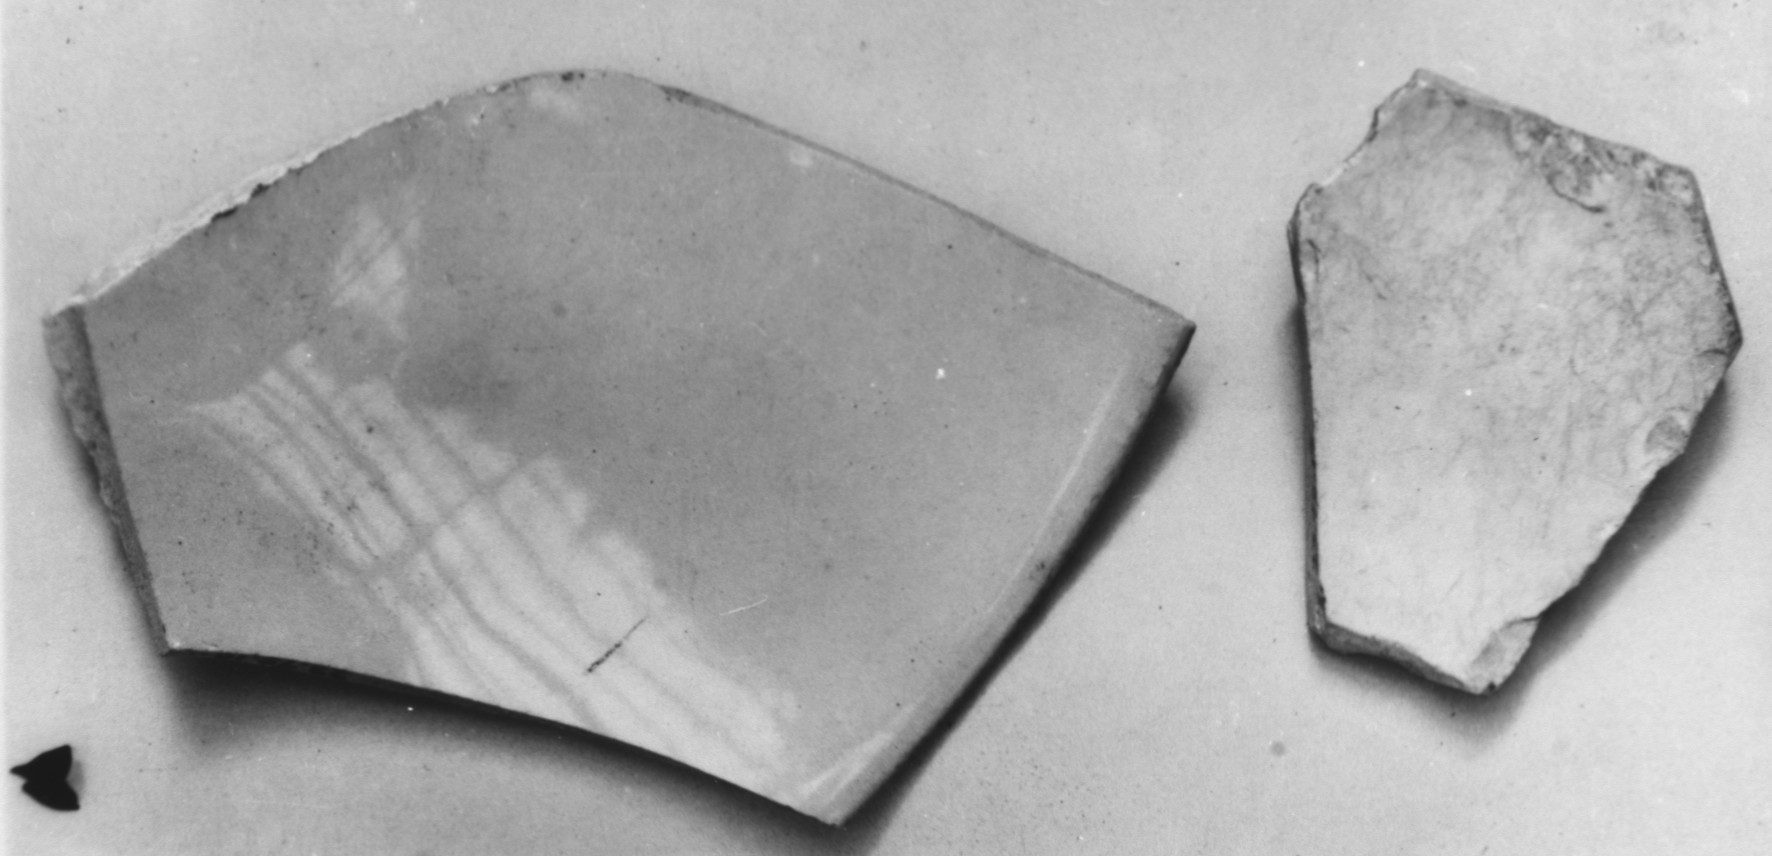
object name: fragment of a bowl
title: Fragment of a Porcelaneous Bowl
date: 801-900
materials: glaze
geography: iraq